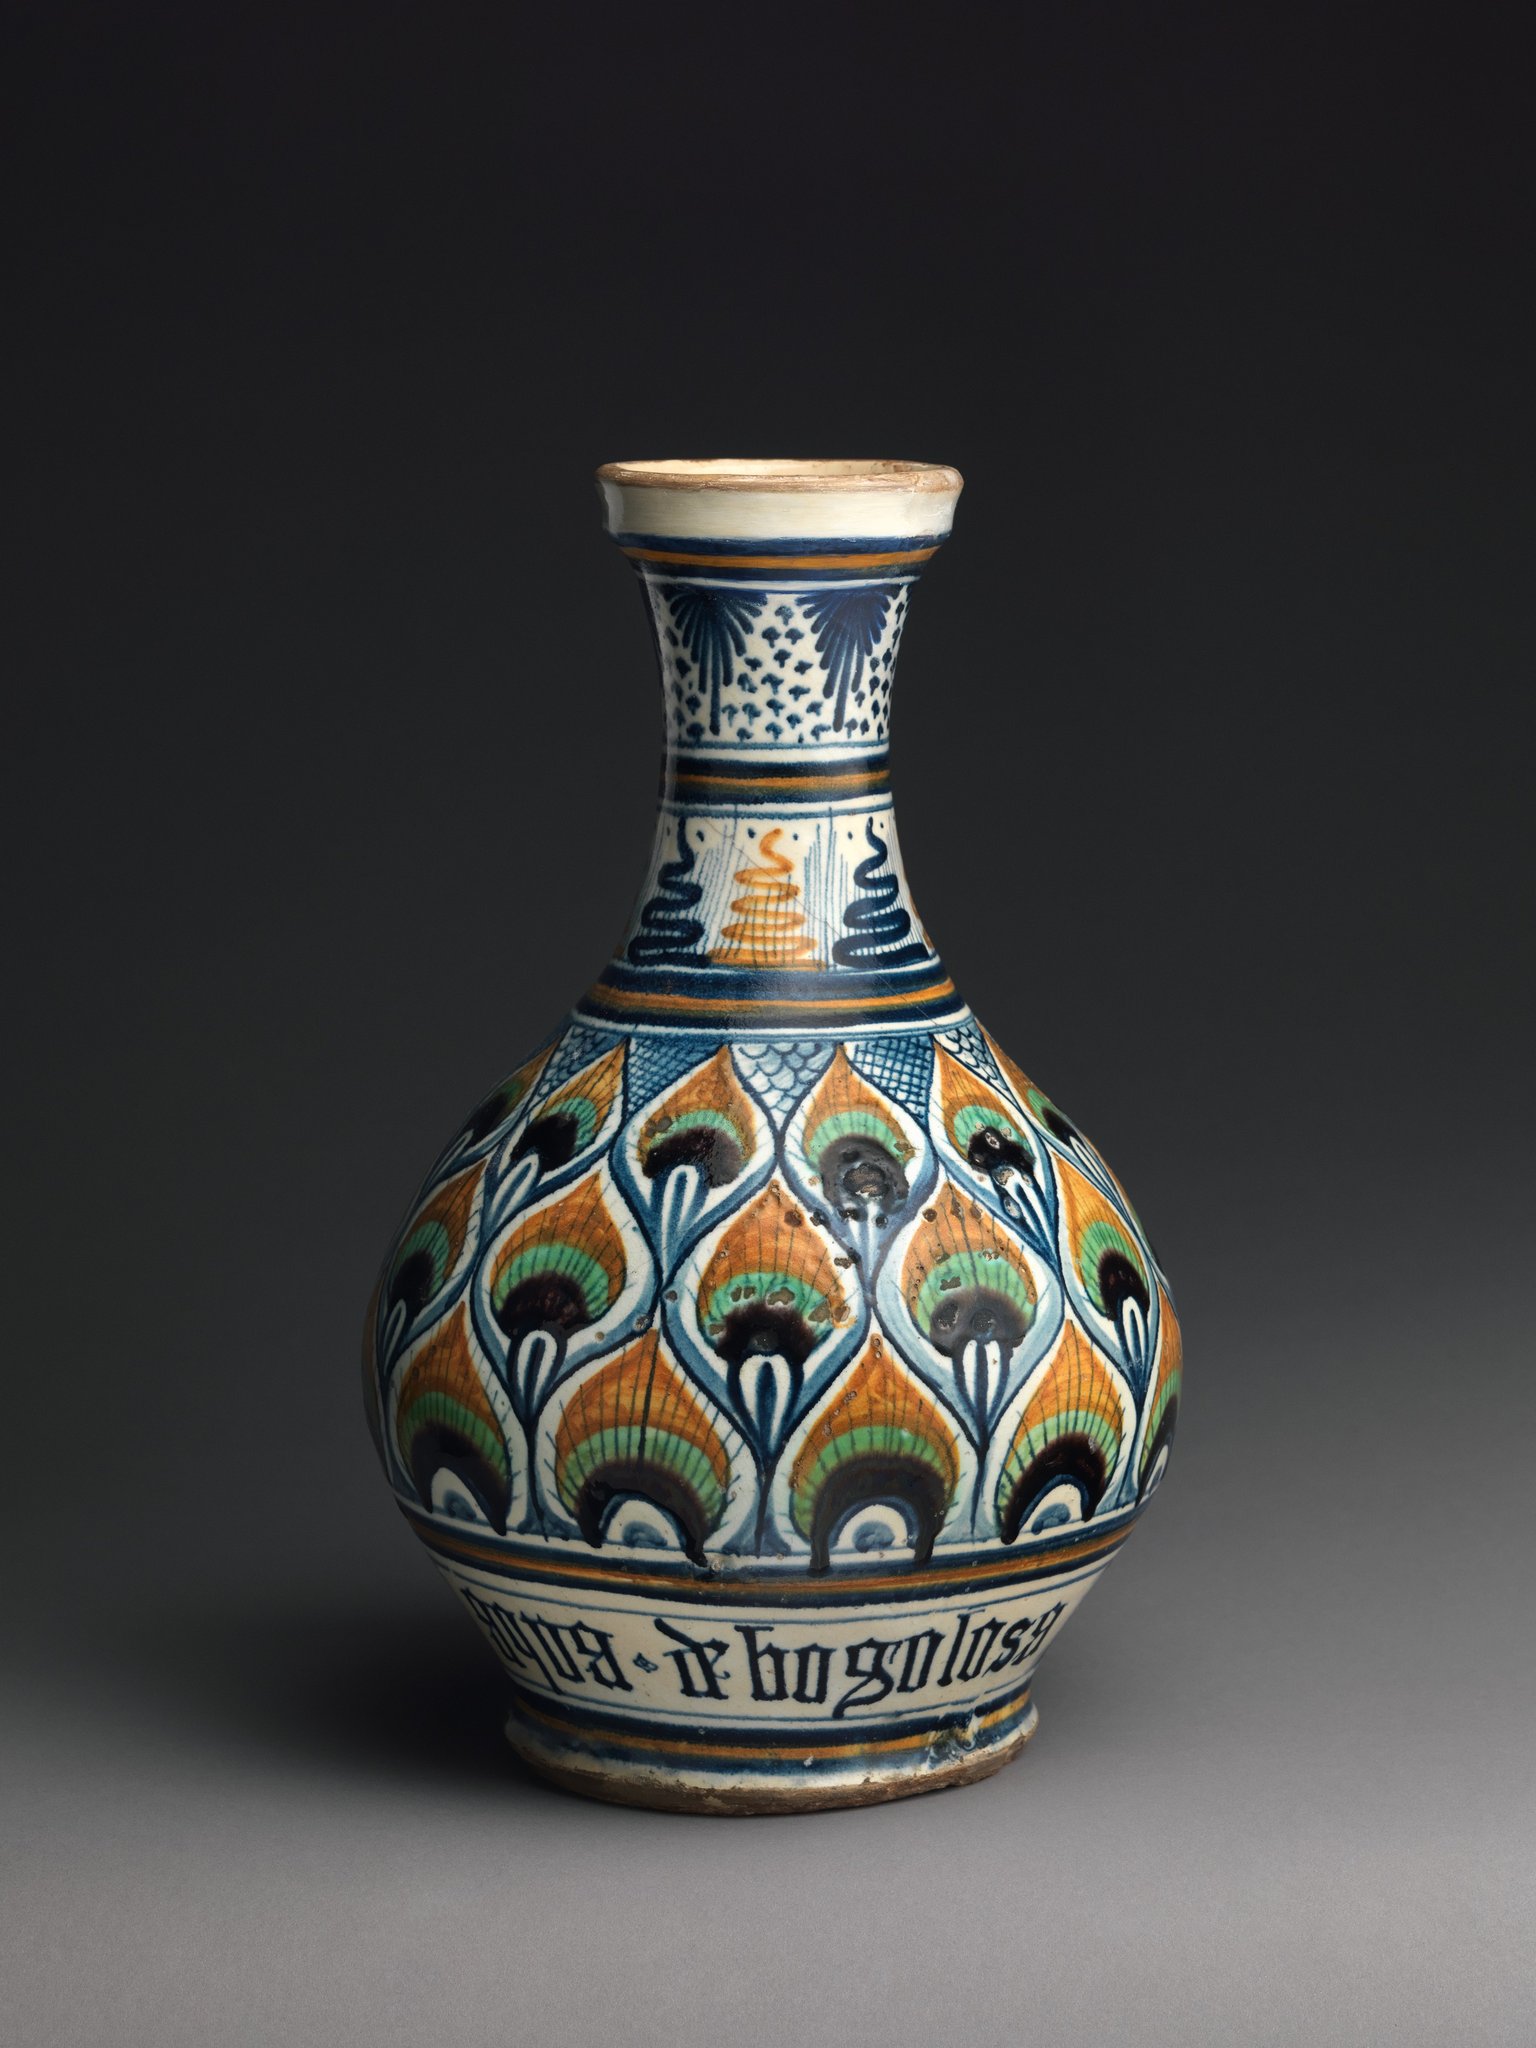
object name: pharmacy bottle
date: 1470-1500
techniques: maiolica, glazing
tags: feathers